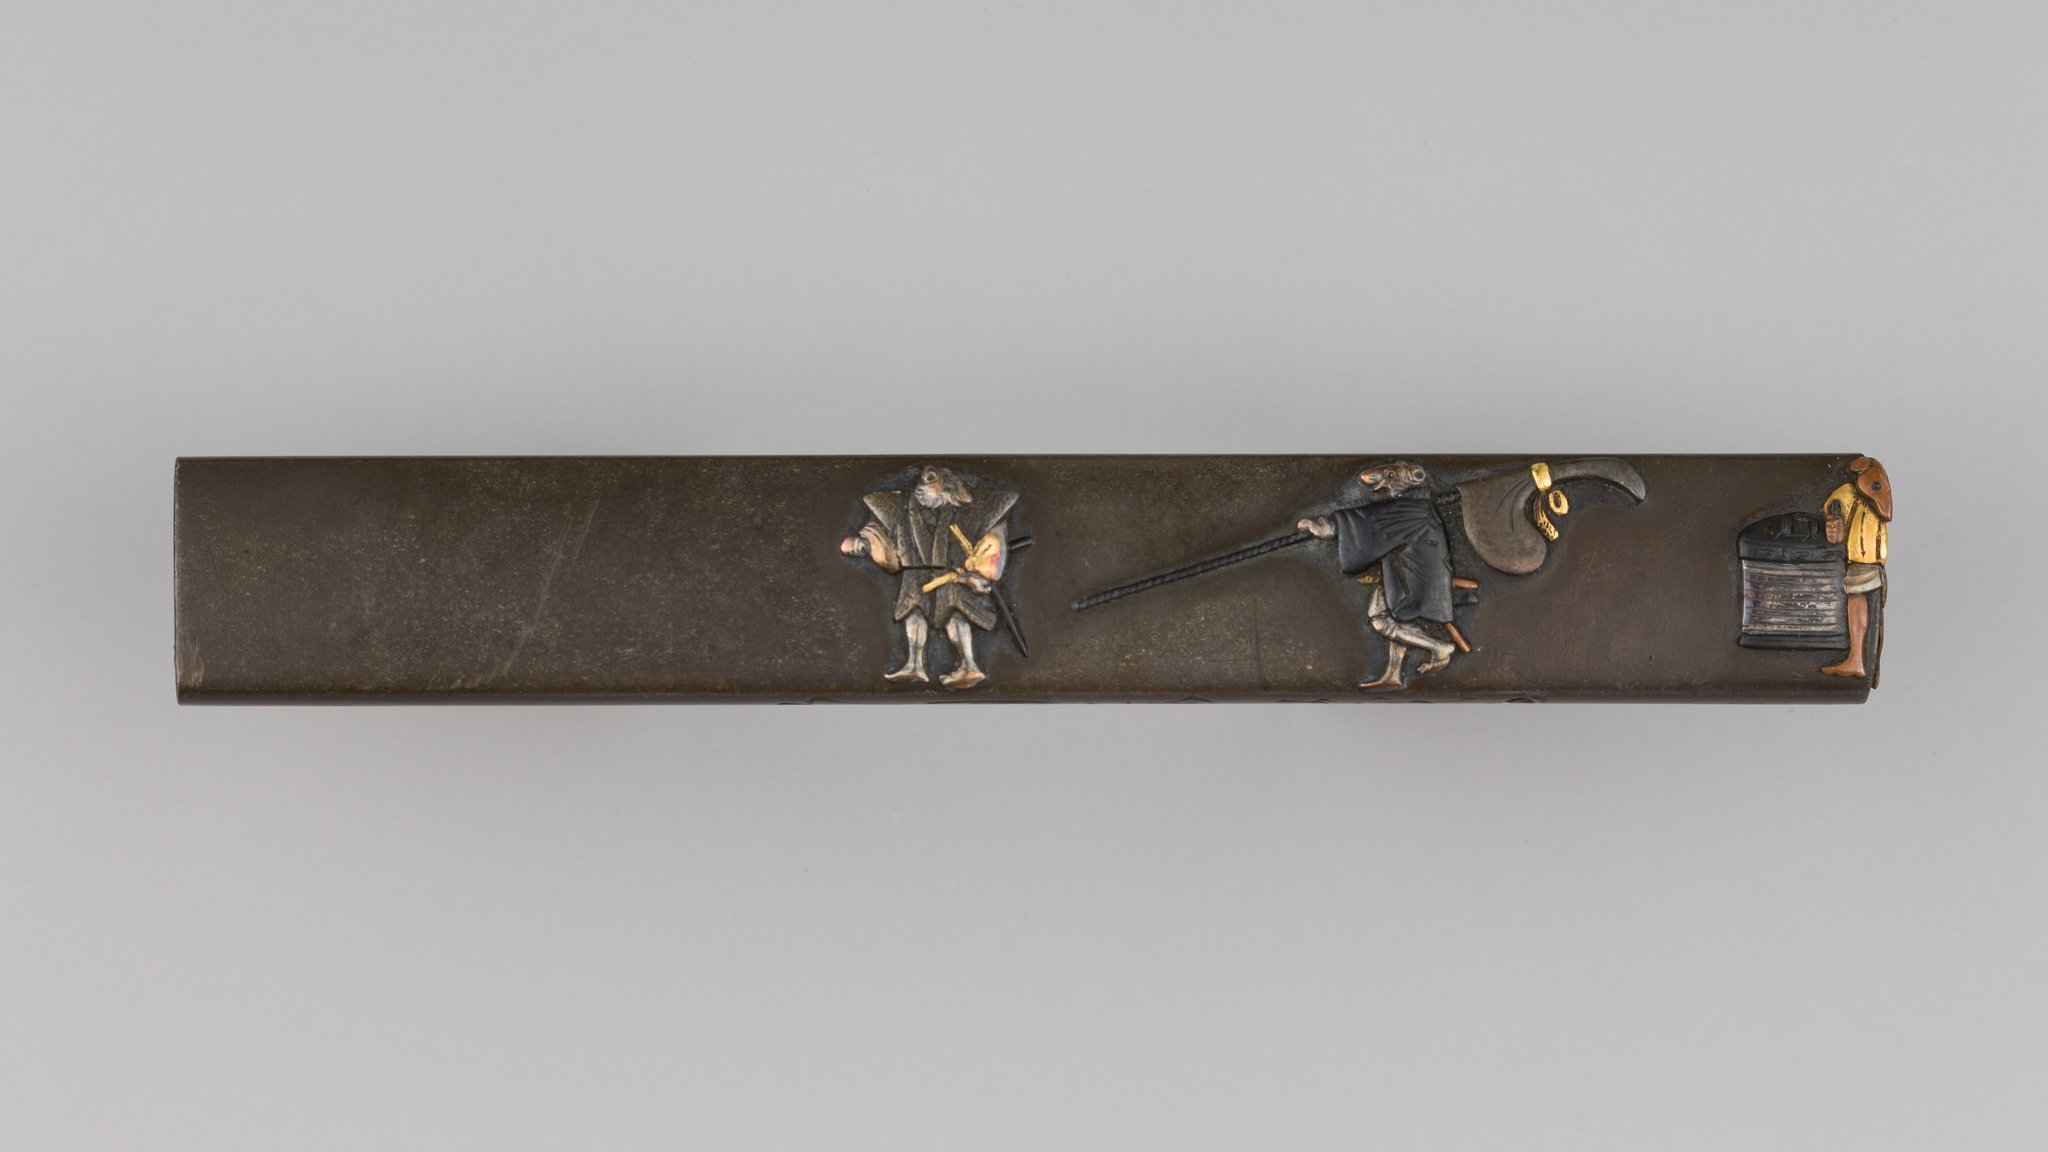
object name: knife handle kozuka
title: Knife Handle (Kozuka)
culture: japanese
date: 1801-1850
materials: copper, silver alloy, gold, silver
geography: japan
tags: mice